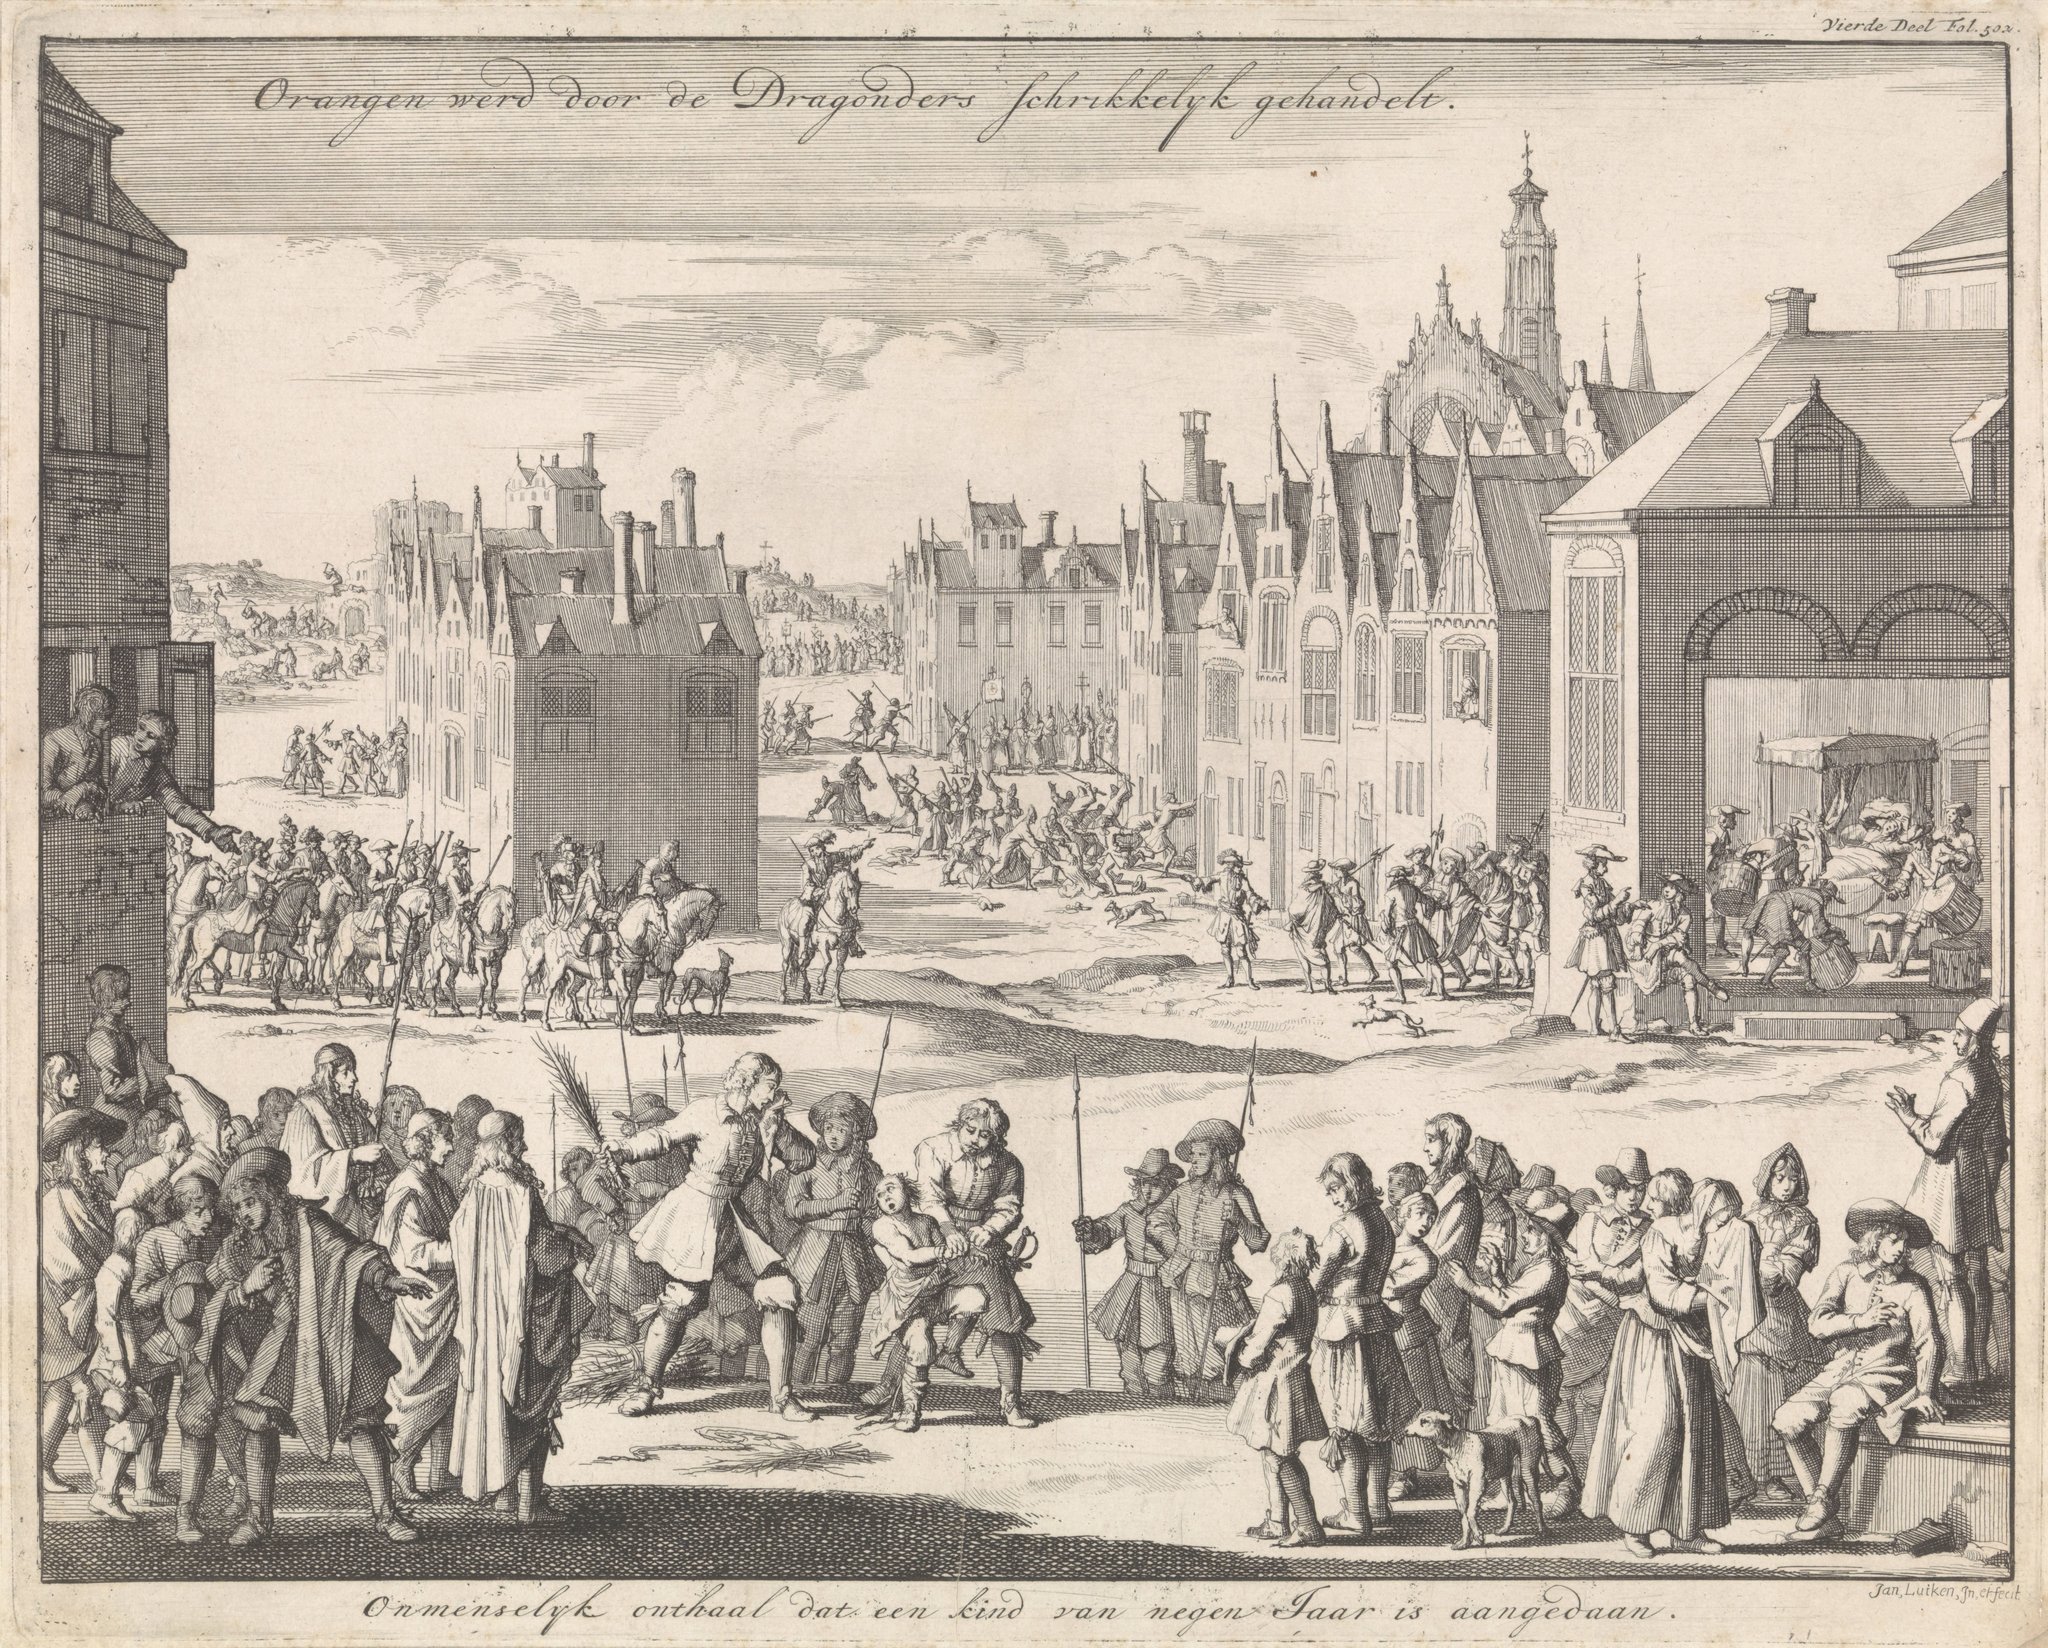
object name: print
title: Orangen werd door de Dragonders schrikkelyk gehandelt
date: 1696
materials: paper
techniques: etching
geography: amsterdam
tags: soldiers taking revenge, persecuted believers (hiding), e.g. huguenots, pilgrim fathers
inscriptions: collector's mark: Lugt 2228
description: Illustratie uit: Benoist, Elie. Historie der gereformeerde kerken van Vrankryk, 4 delen. Amsterdam: Jan Claesz ten Hoorn, 1696, dl. IV.